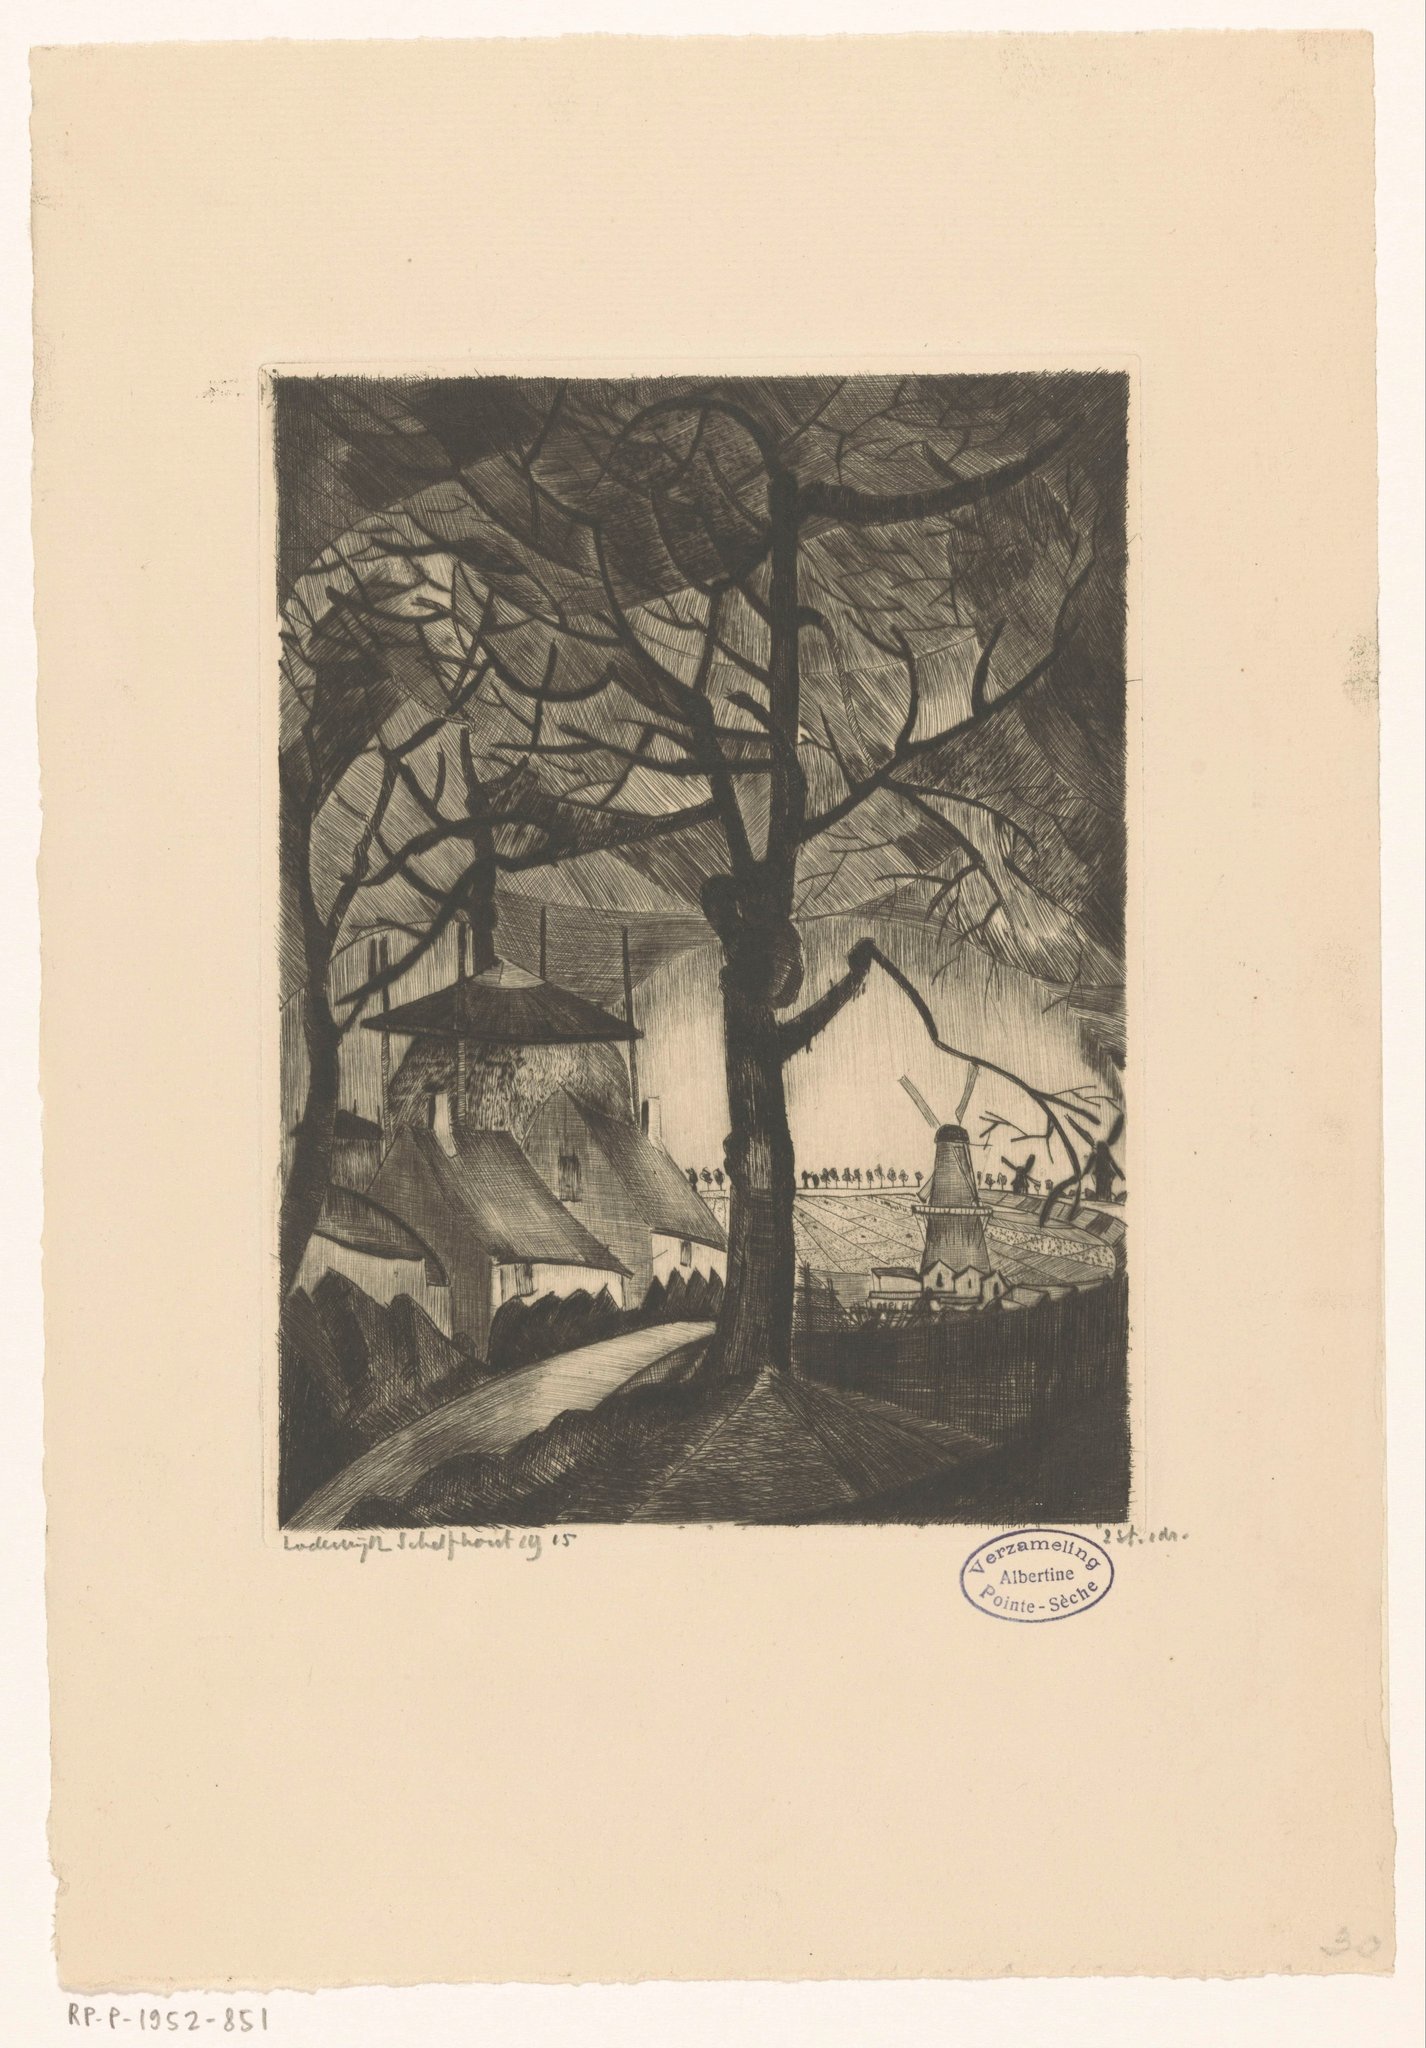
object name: print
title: Les Fermes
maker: lodewijk schelfhout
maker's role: draughtsman, print maker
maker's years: 1881-1943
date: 1915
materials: paper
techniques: drypoint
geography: netherlands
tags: trees, windmill in landscape, farm or solitary house in landscape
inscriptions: collector's mark: Lugt 2228, collector's mark: Lugt 5i, collector's mark: Lugt 2760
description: Een boerderij met hooischuur in een glooiend landschap met akkers en een molen. Op de voorgrond een boom.